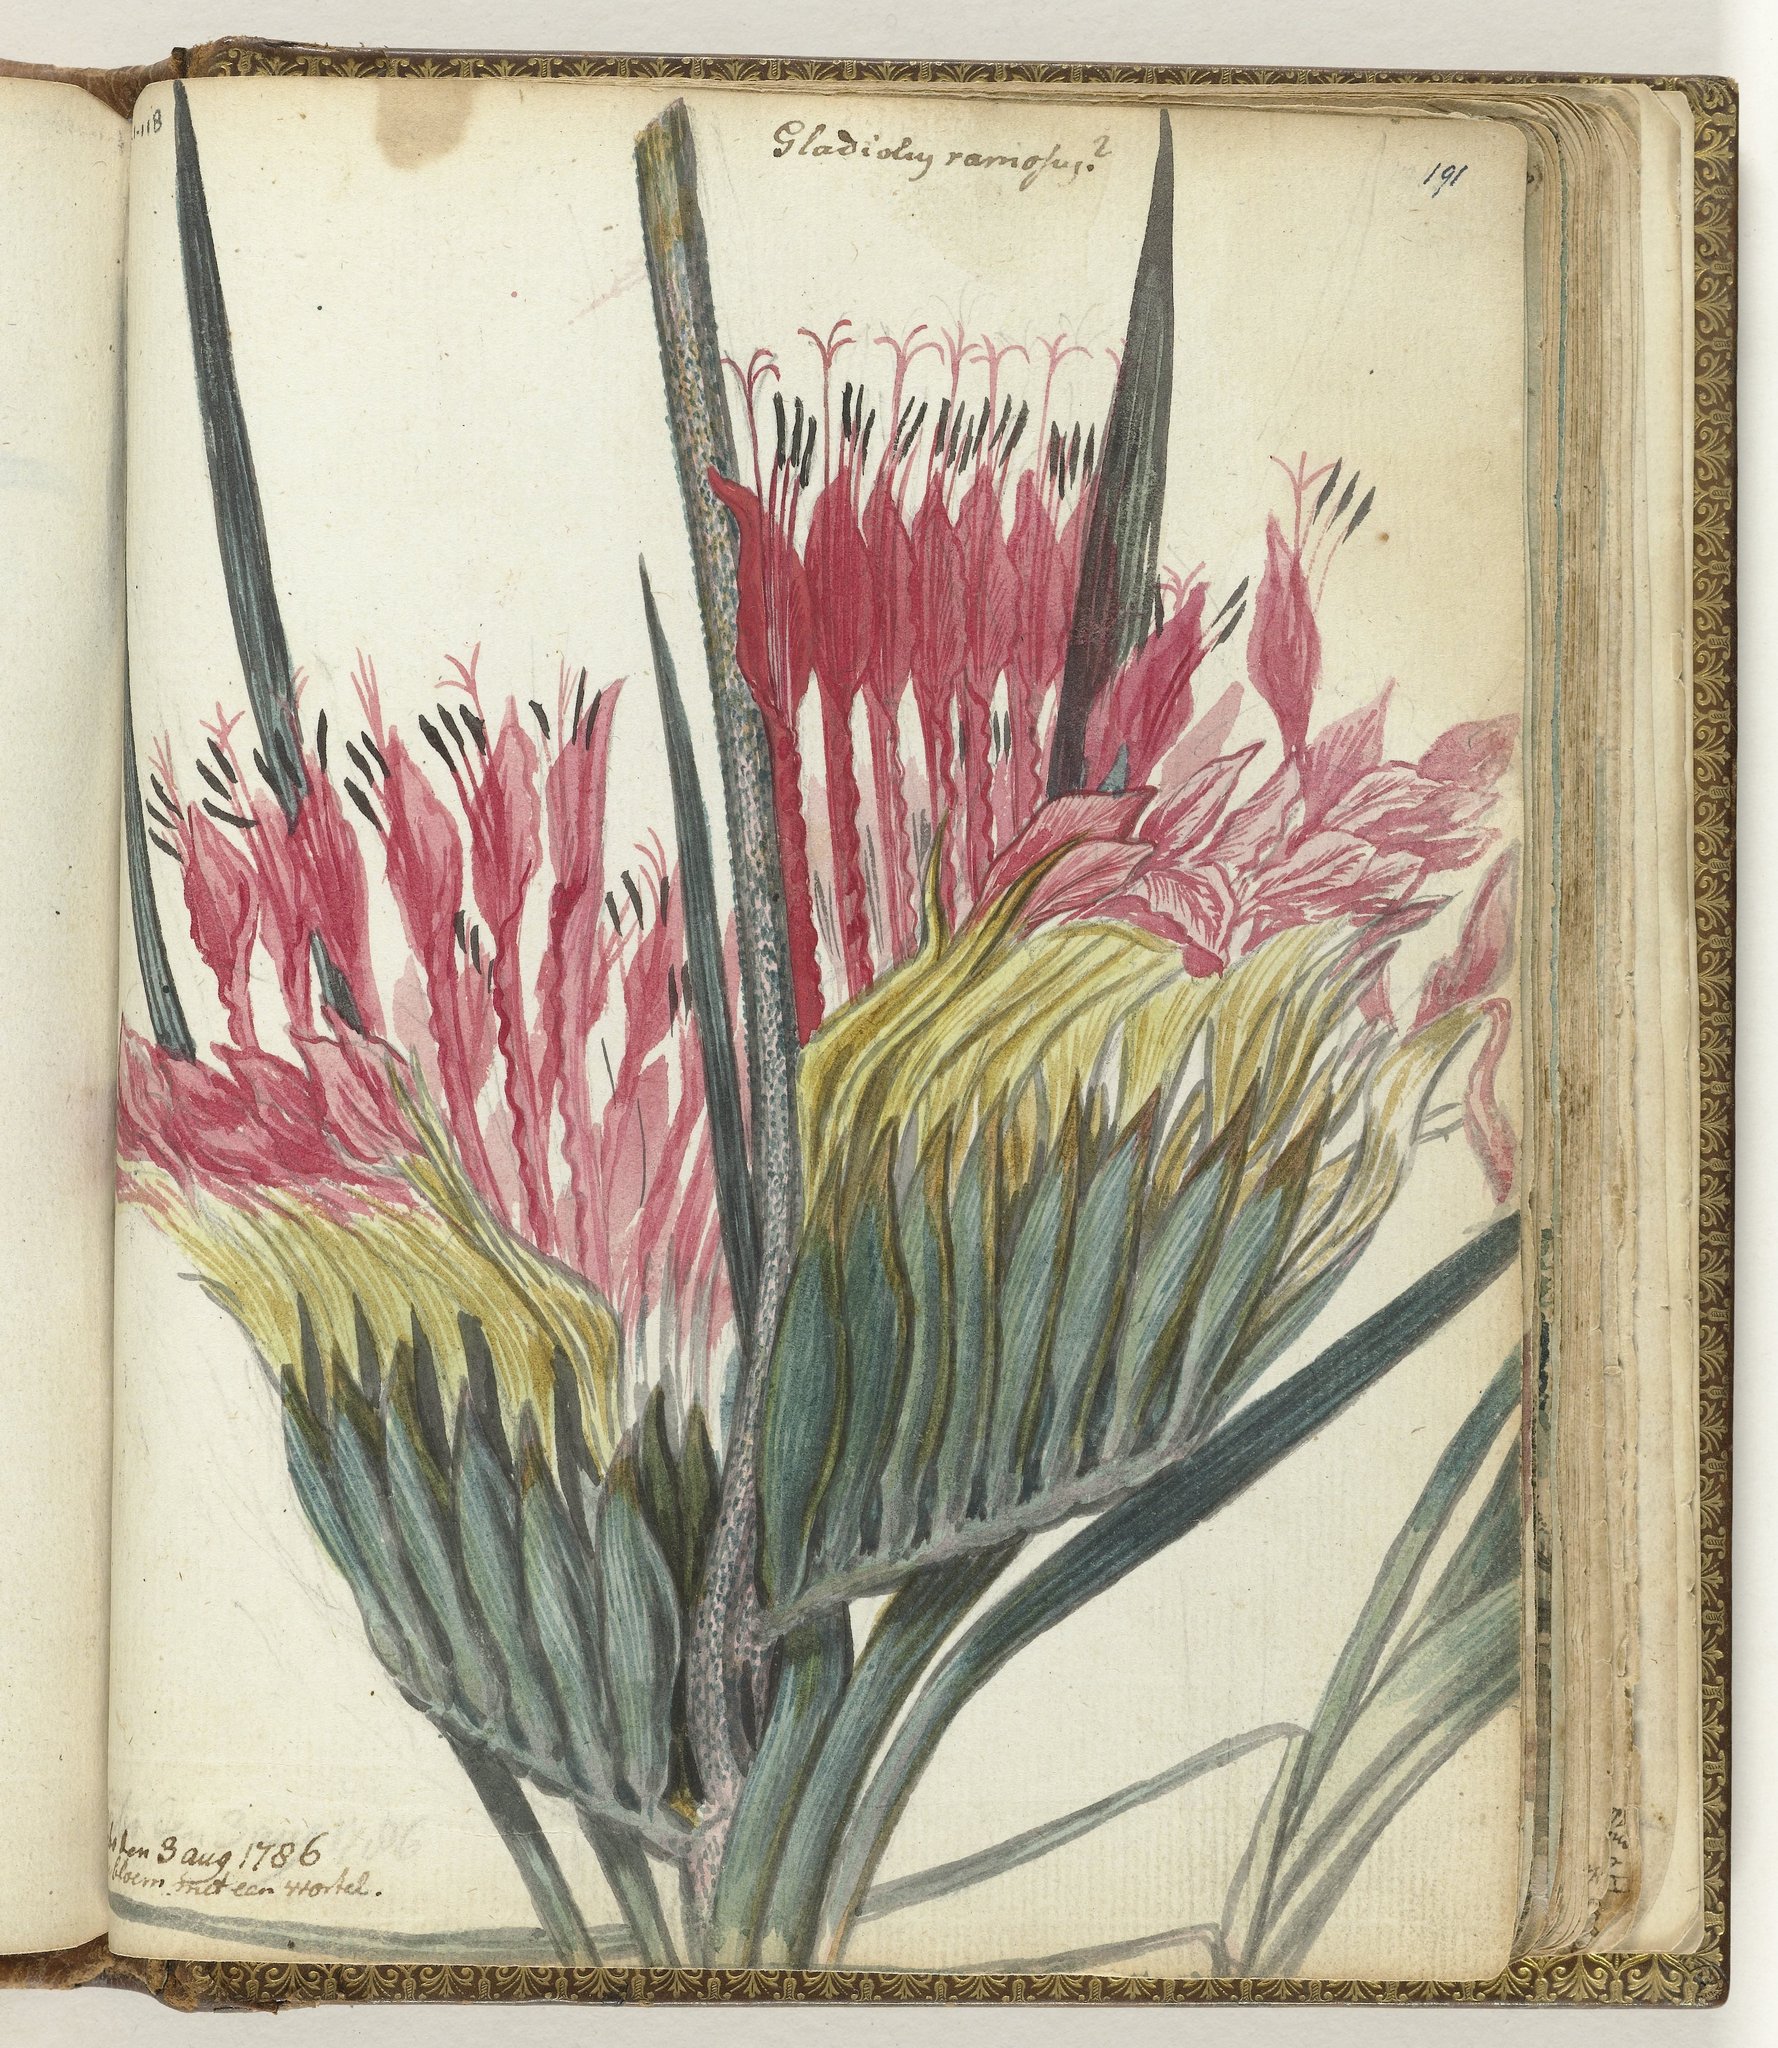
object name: drawing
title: Kaapse bloem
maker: jan brandes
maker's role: draughtsman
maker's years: 1743-1808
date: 1786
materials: paper, pencil, watercolor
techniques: brush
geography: cape of good hope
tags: flowers, cape of good hope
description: Kleurtekening van een bloem die voorkomt op Kaap de Goede Hoop. Met opschrift. Onderdeel uit het schetsboek van Jan Brandes, dl. 1 (1808), p. 191.